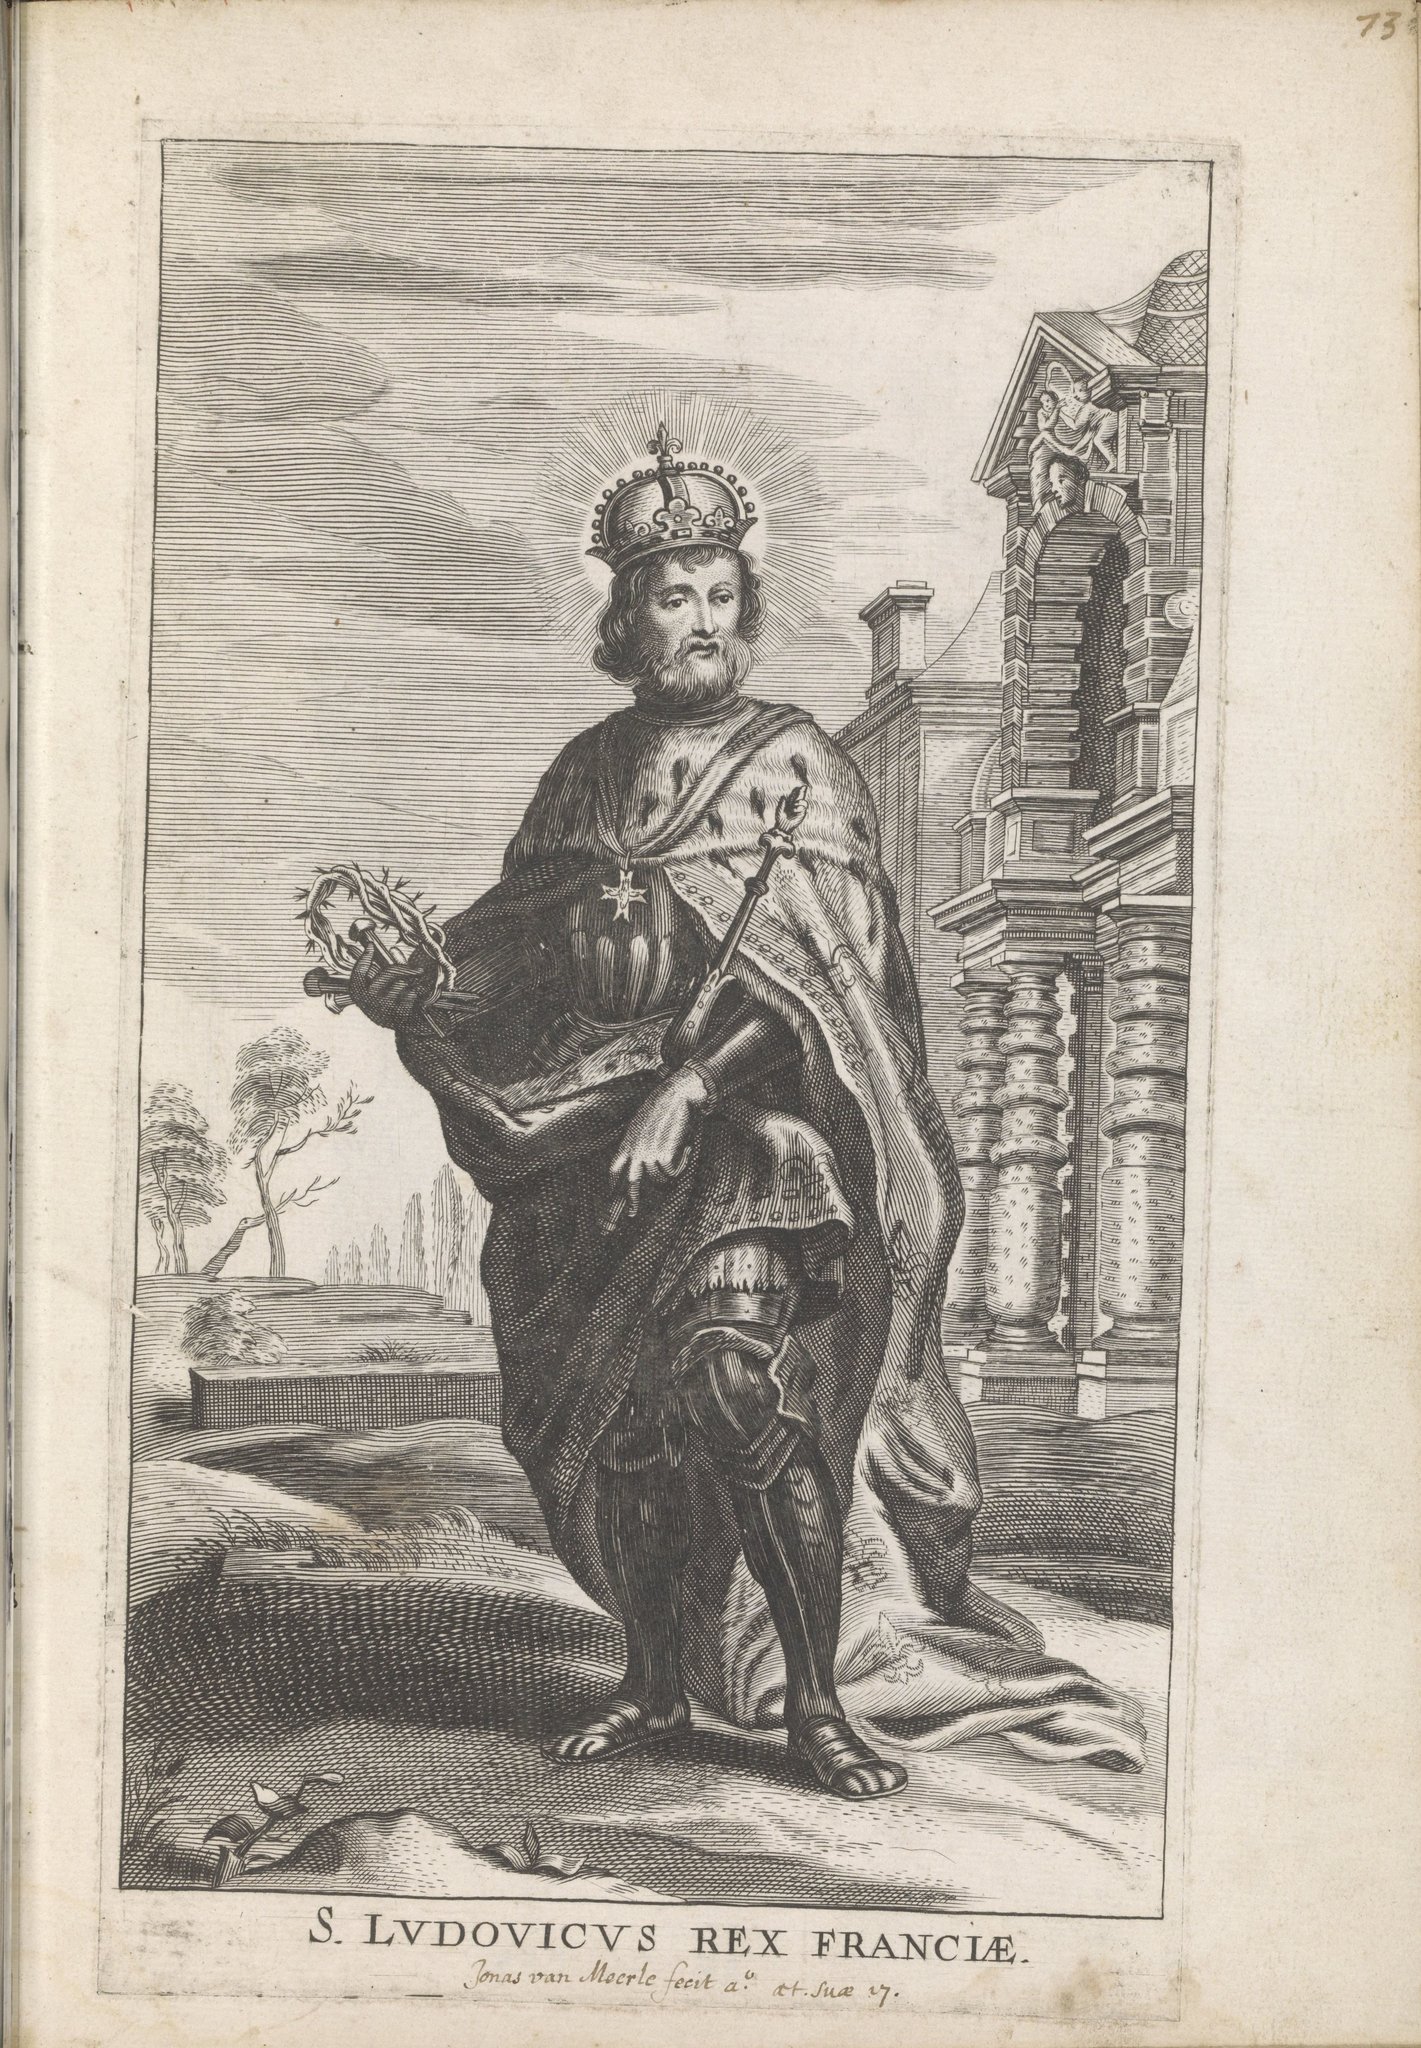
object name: album leaf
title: Lodewijk IX, koning van Frankrijk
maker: jonas van merle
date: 1593-1650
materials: paper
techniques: engraving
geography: low countries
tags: st. louis ix carrying relics (crown of thorns and three nails) towards the sainte-chapelle in paris, louis ix, king of france; possible attributes: crown of thorns, fleur-de-lis on his coat, three nails, sceptre with fleur-de-lis, model of church, hand of justice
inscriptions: inscription: ‘Jonas van Meerle fecit ao. at. suae 17’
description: Lodewijk IX de Heilige, koning van Frankrijk, draagt de relieken van Christus: doornenkroon en drie nagels, naar de Sainte-Chapelle in Parijs. Prent maakt deel uit van een album.